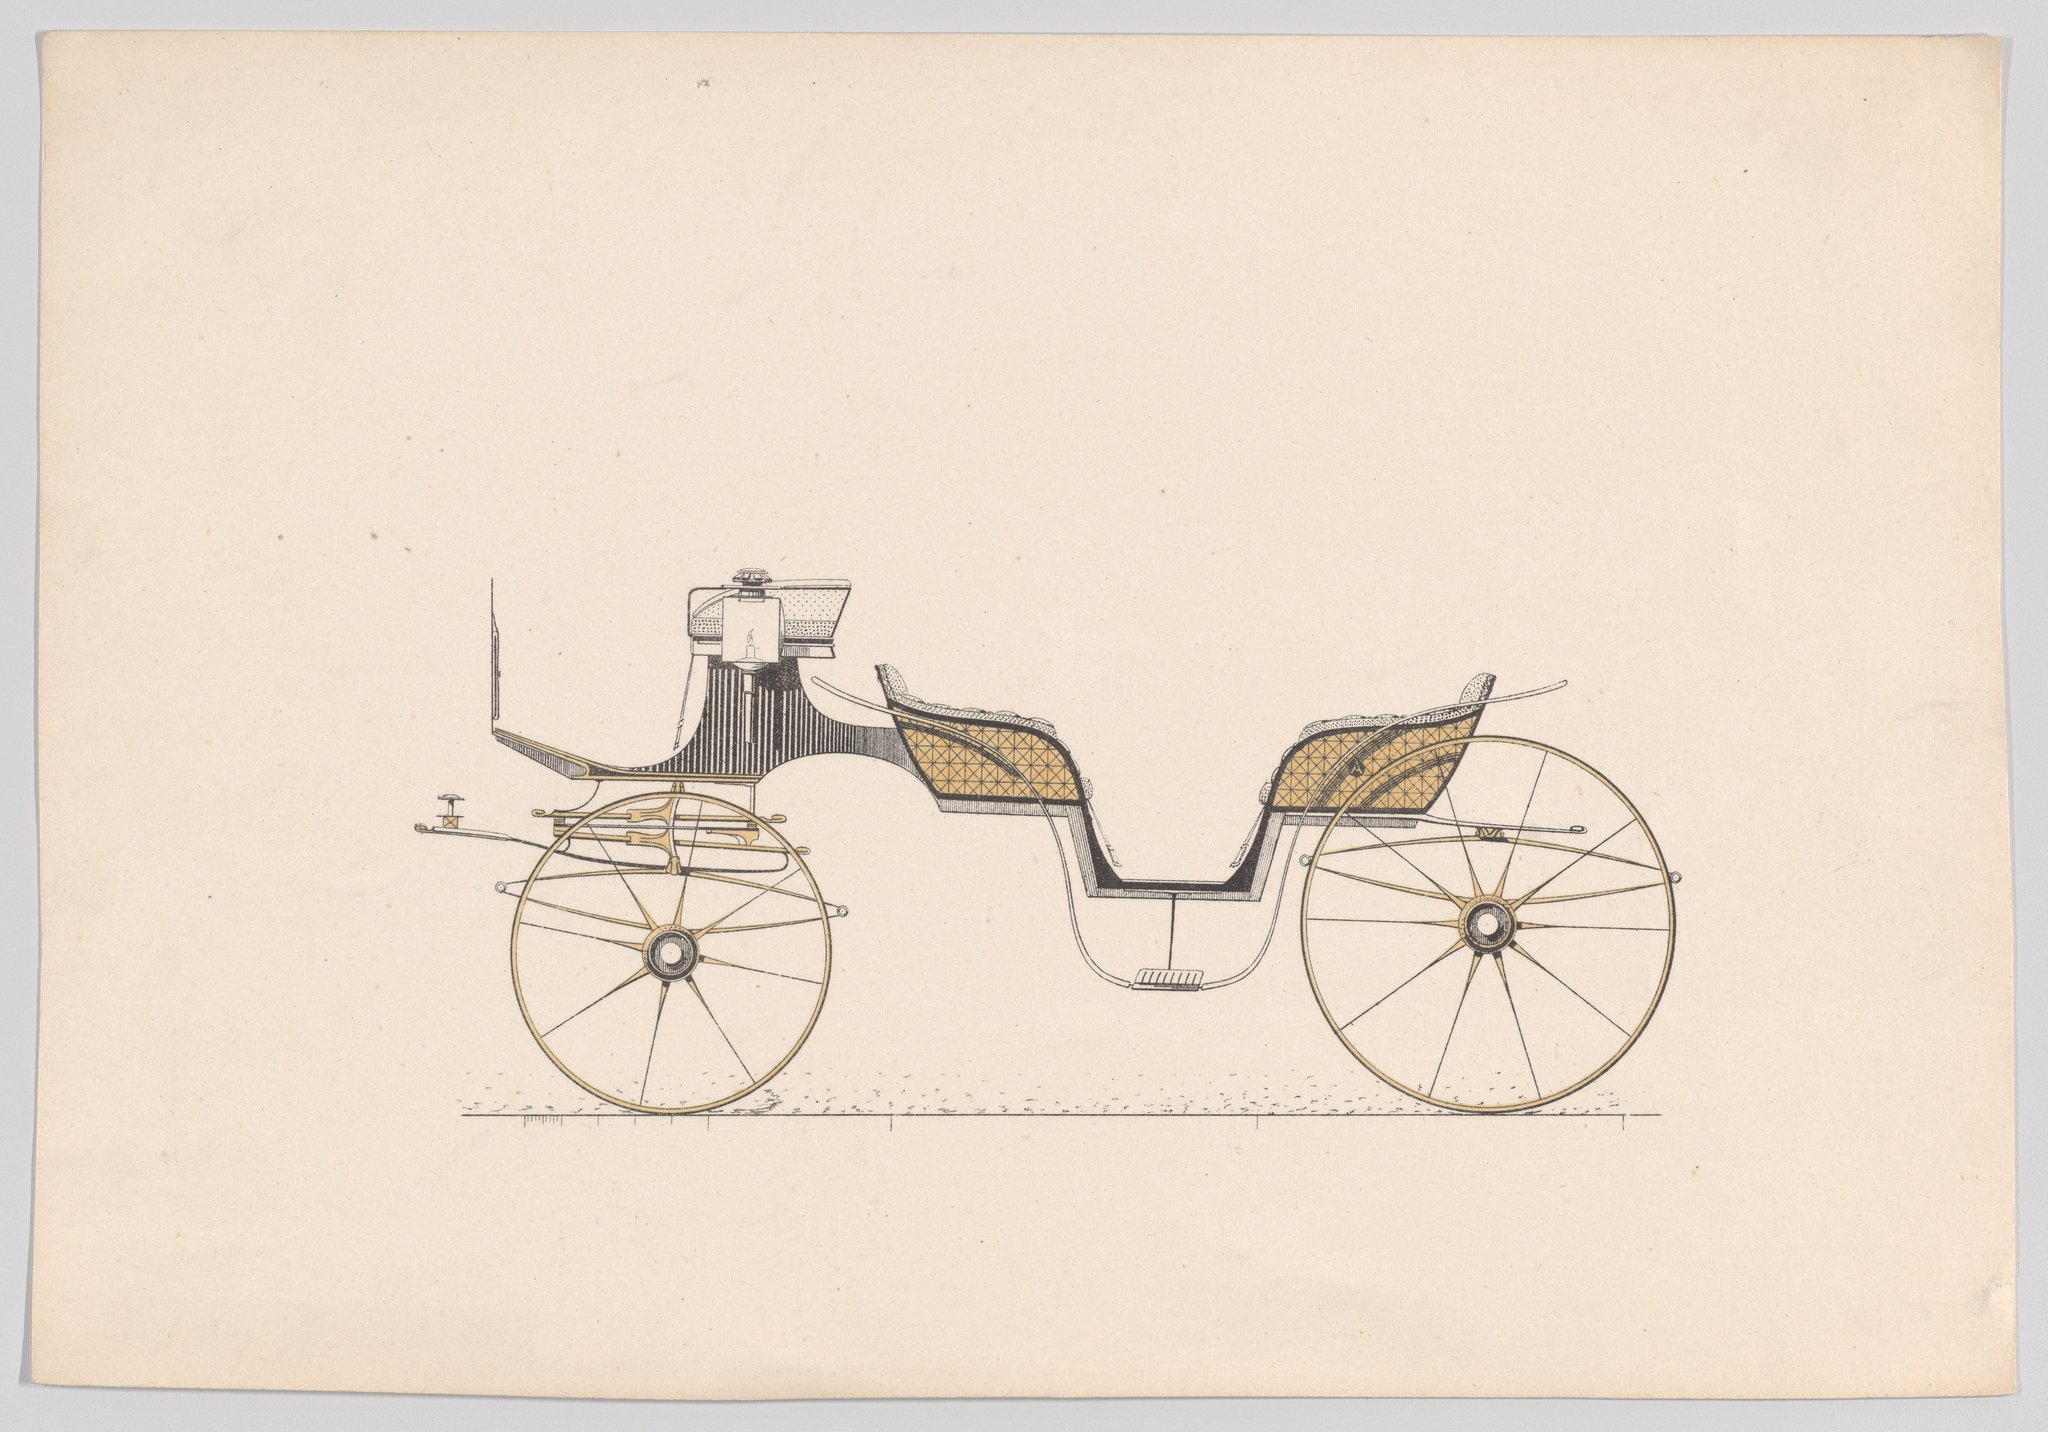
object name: print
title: Design for Vis-a-Vis Carriage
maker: anonymous, french, 19th century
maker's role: artist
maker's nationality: french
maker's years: 1800-1900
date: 1870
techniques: hand coloring, lithograph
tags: carriages